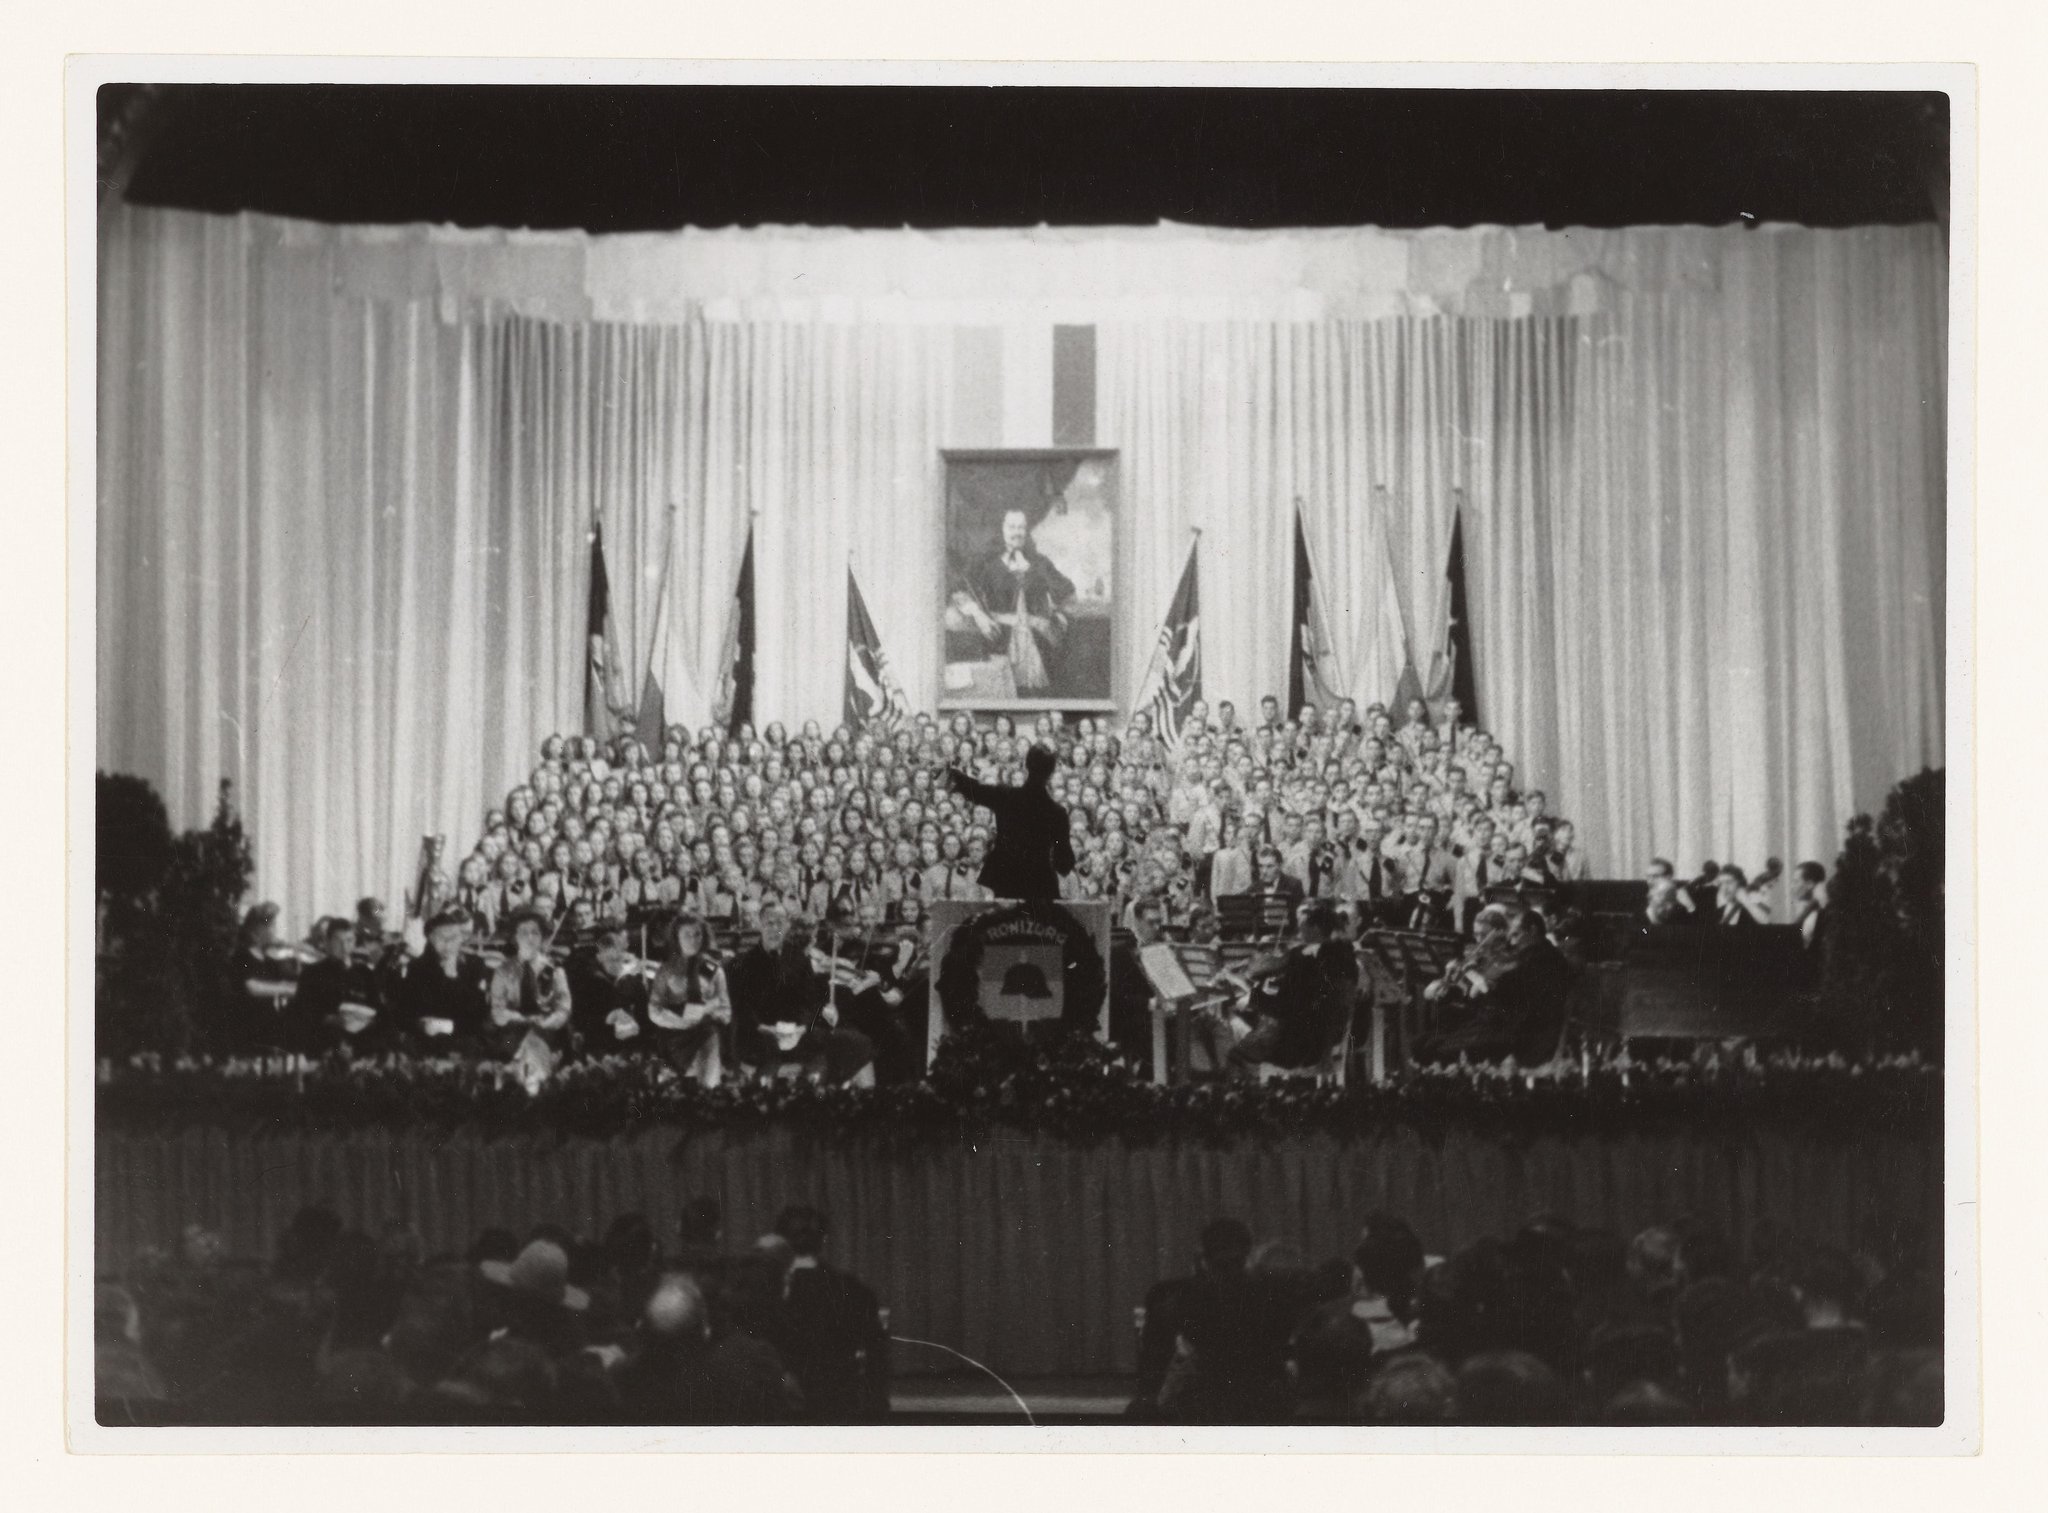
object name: photograph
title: Jeugdstorm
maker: j.h. hasewinkel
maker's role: fotograaf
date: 1944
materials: photographic support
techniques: photography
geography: utrecht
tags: flushing, michiel adriaenszoon de ruyter, military celebrations, choir, utrecht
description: In een zaal van theater Tivoli in Utrecht staat een koor van de Jeugdstorm opgesteld met een orkest. Het betreft de uitvoering van de De Ruyter cantate, geschreven eind 19de eeuw. Achter het koor een portret van Michiel Adriaenszoon de Ruyter (kopie naar het schilderij door Ferdinand Bol in het Rijksmuseum) geflankeerd door vlaggen waaronder die van de Jeugdstorm.